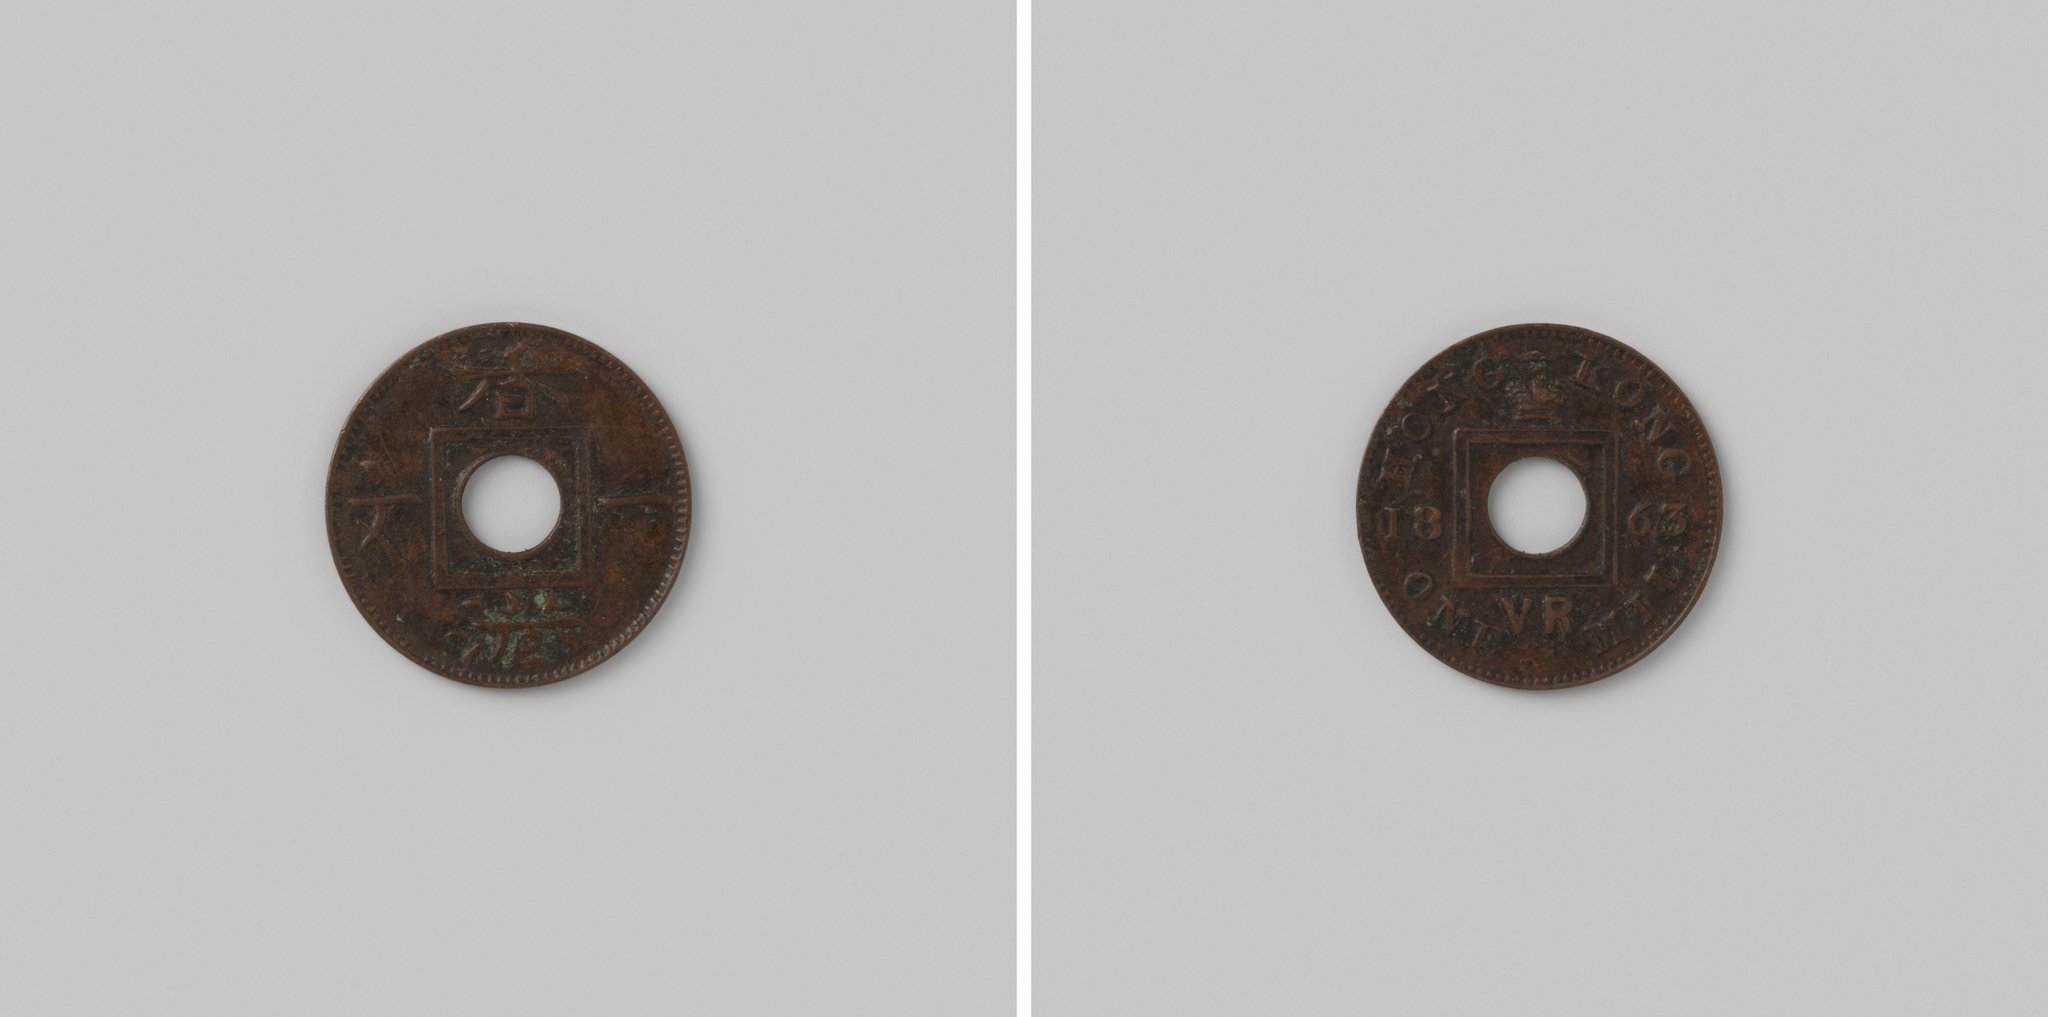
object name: coin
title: Mil of wen uit Hongkong van koningin Victoria, 1863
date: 1863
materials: bronze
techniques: striking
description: Bronzen munt. Voorzijde: rondom ronde uitsparing in het midden vier kruisgewijze geplaatste Chinese tekens, waaronder rechts liggende streep [=een]. Keerzijde: rondom uitsparing in het midden jaartal. Onderaan waarde-aanduiding: one mil, waarboven de letters VR [=Victoria Regina]. Gladde rand.